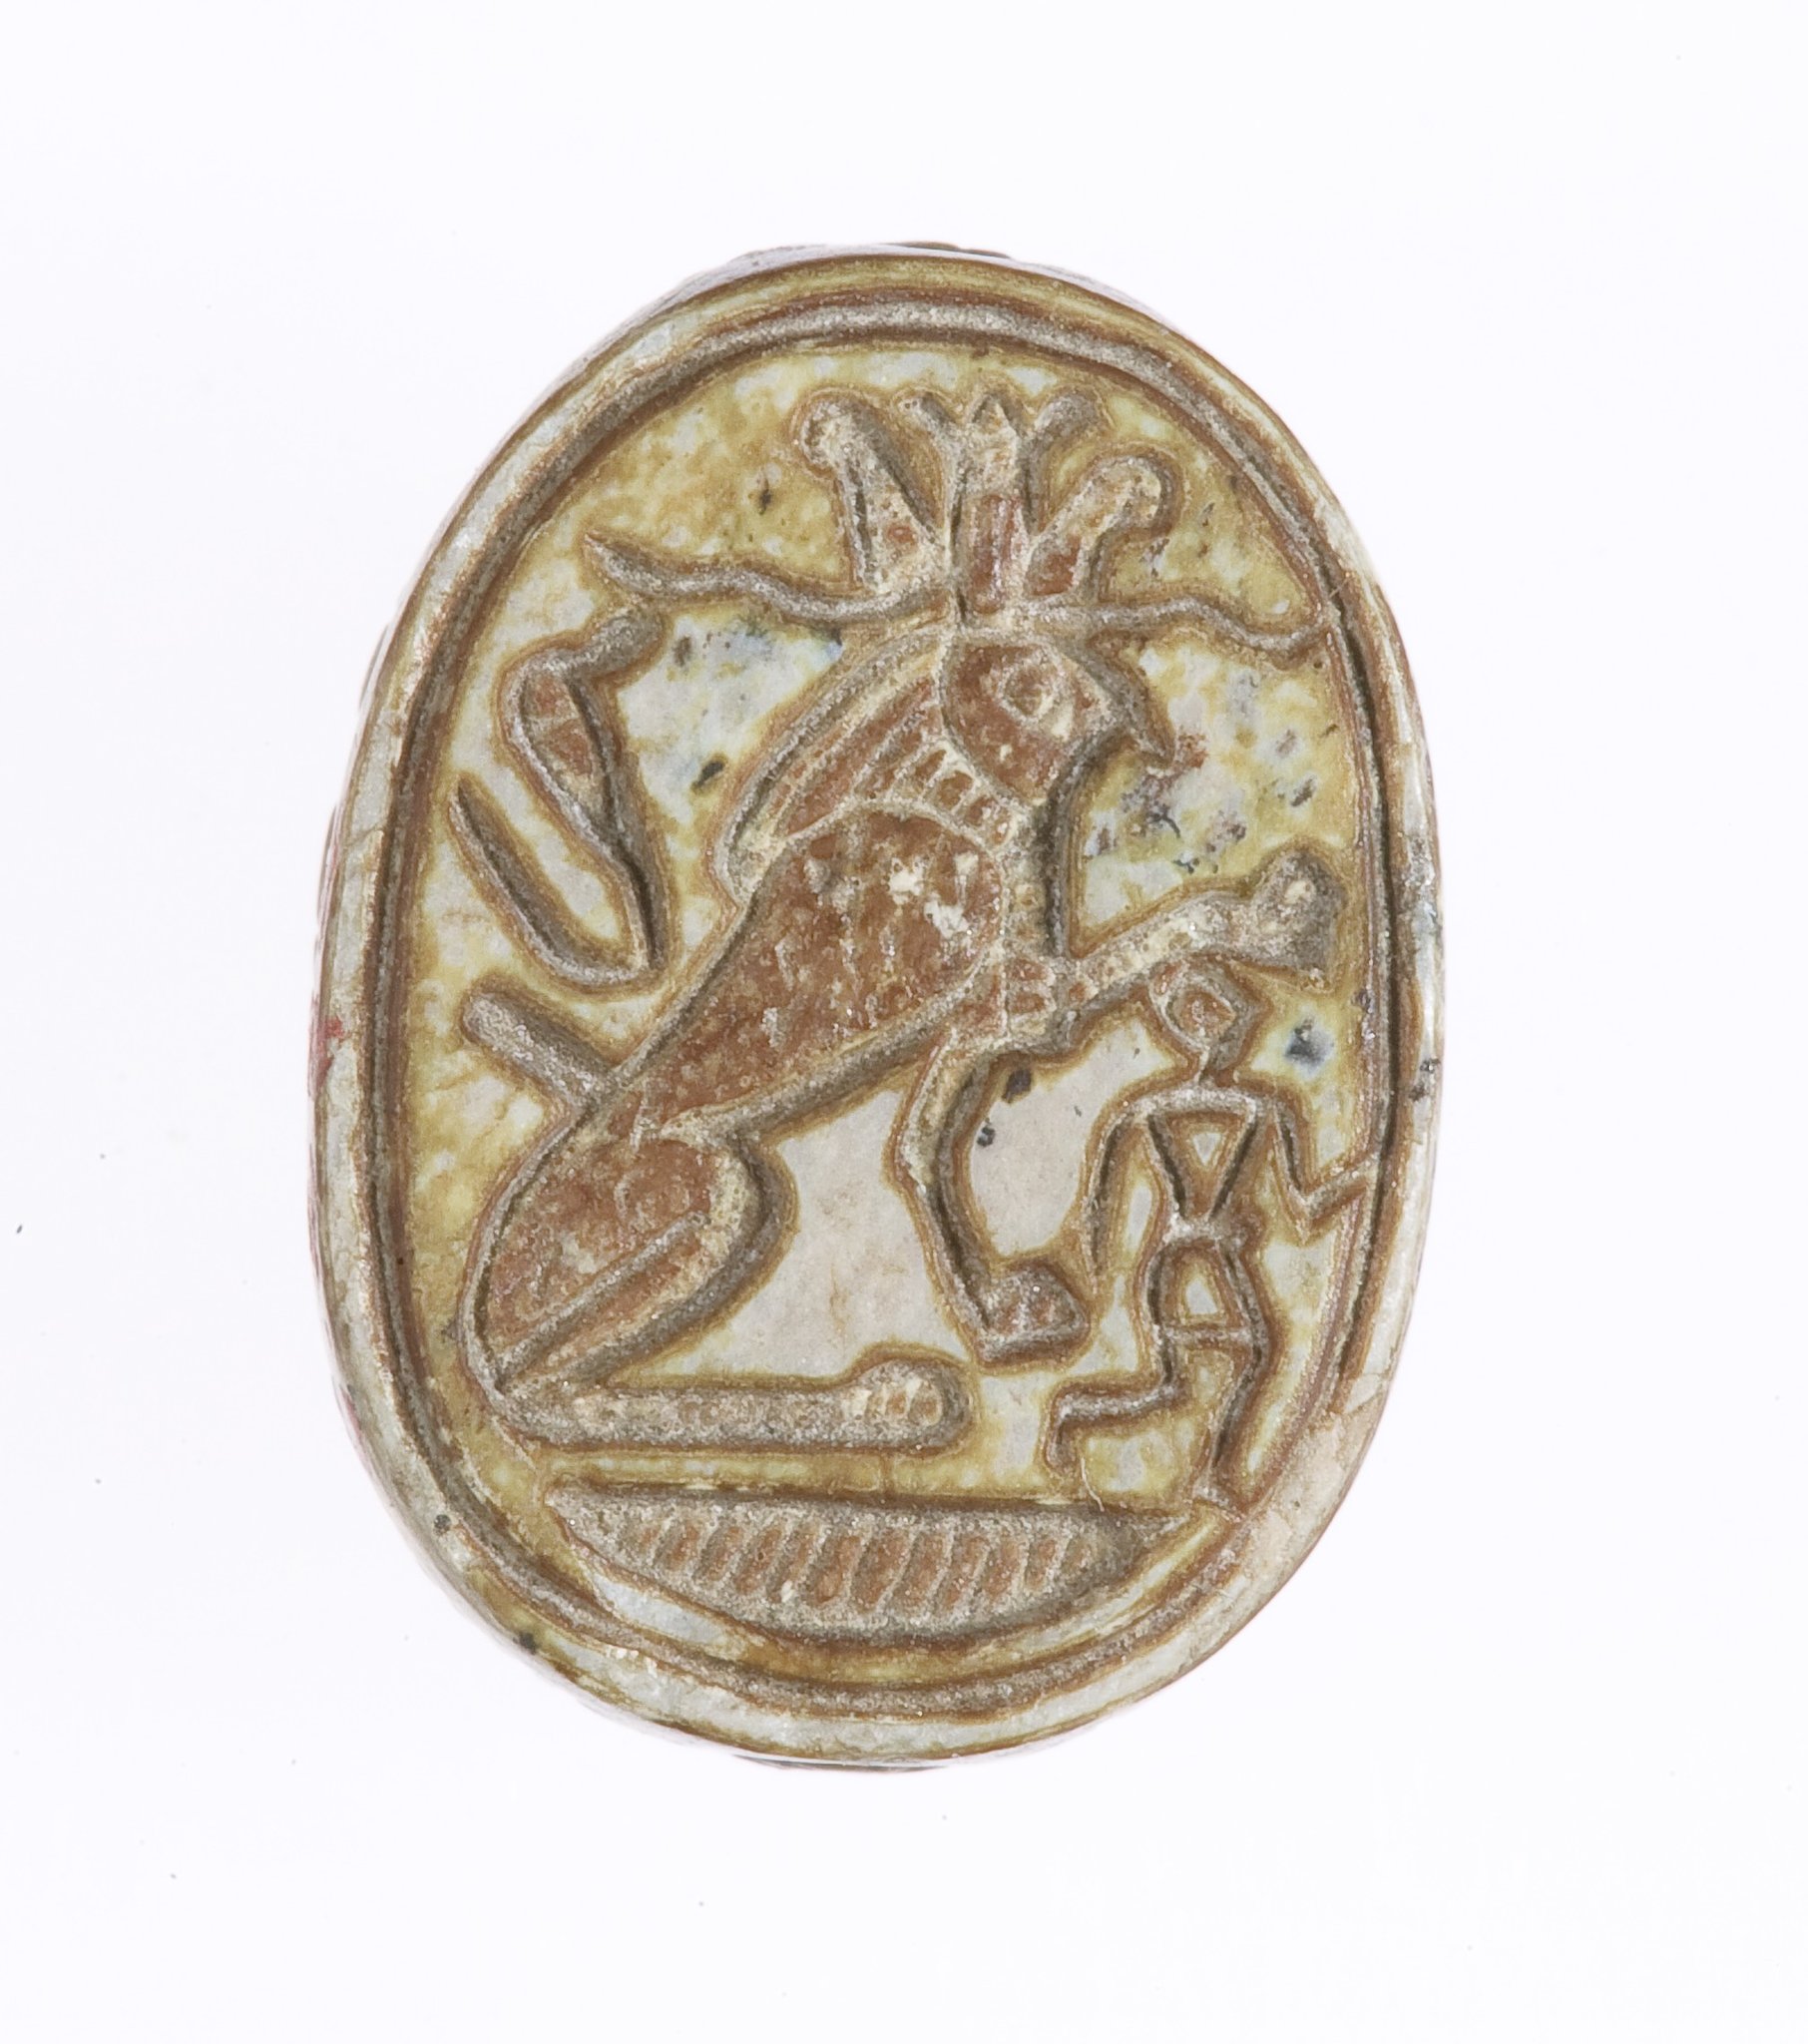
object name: scarab, lion headed sphinx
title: Scarab Inscribed With a Protective Motif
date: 1550-1458 BCE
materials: stone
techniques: glazing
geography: egypt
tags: birds,sphinx,scarabs